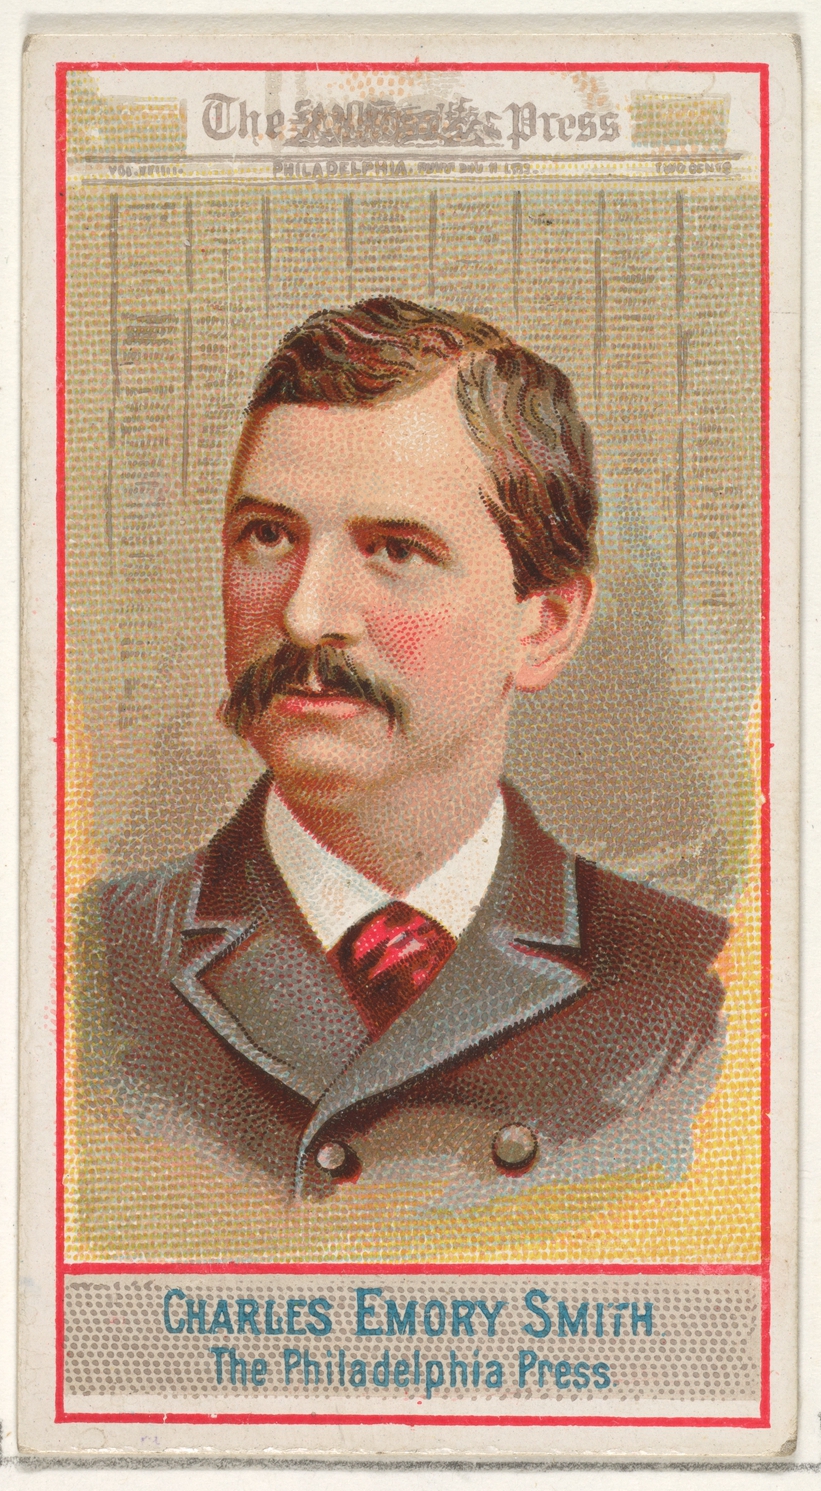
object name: print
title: Charles Emory Smith, The Philadelphia Press, from the American Editors series (N1) for Allen & Ginter Cigarettes Brands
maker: allen & ginter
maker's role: publisher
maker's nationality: american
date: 1887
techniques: color lithograph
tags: men,portraits